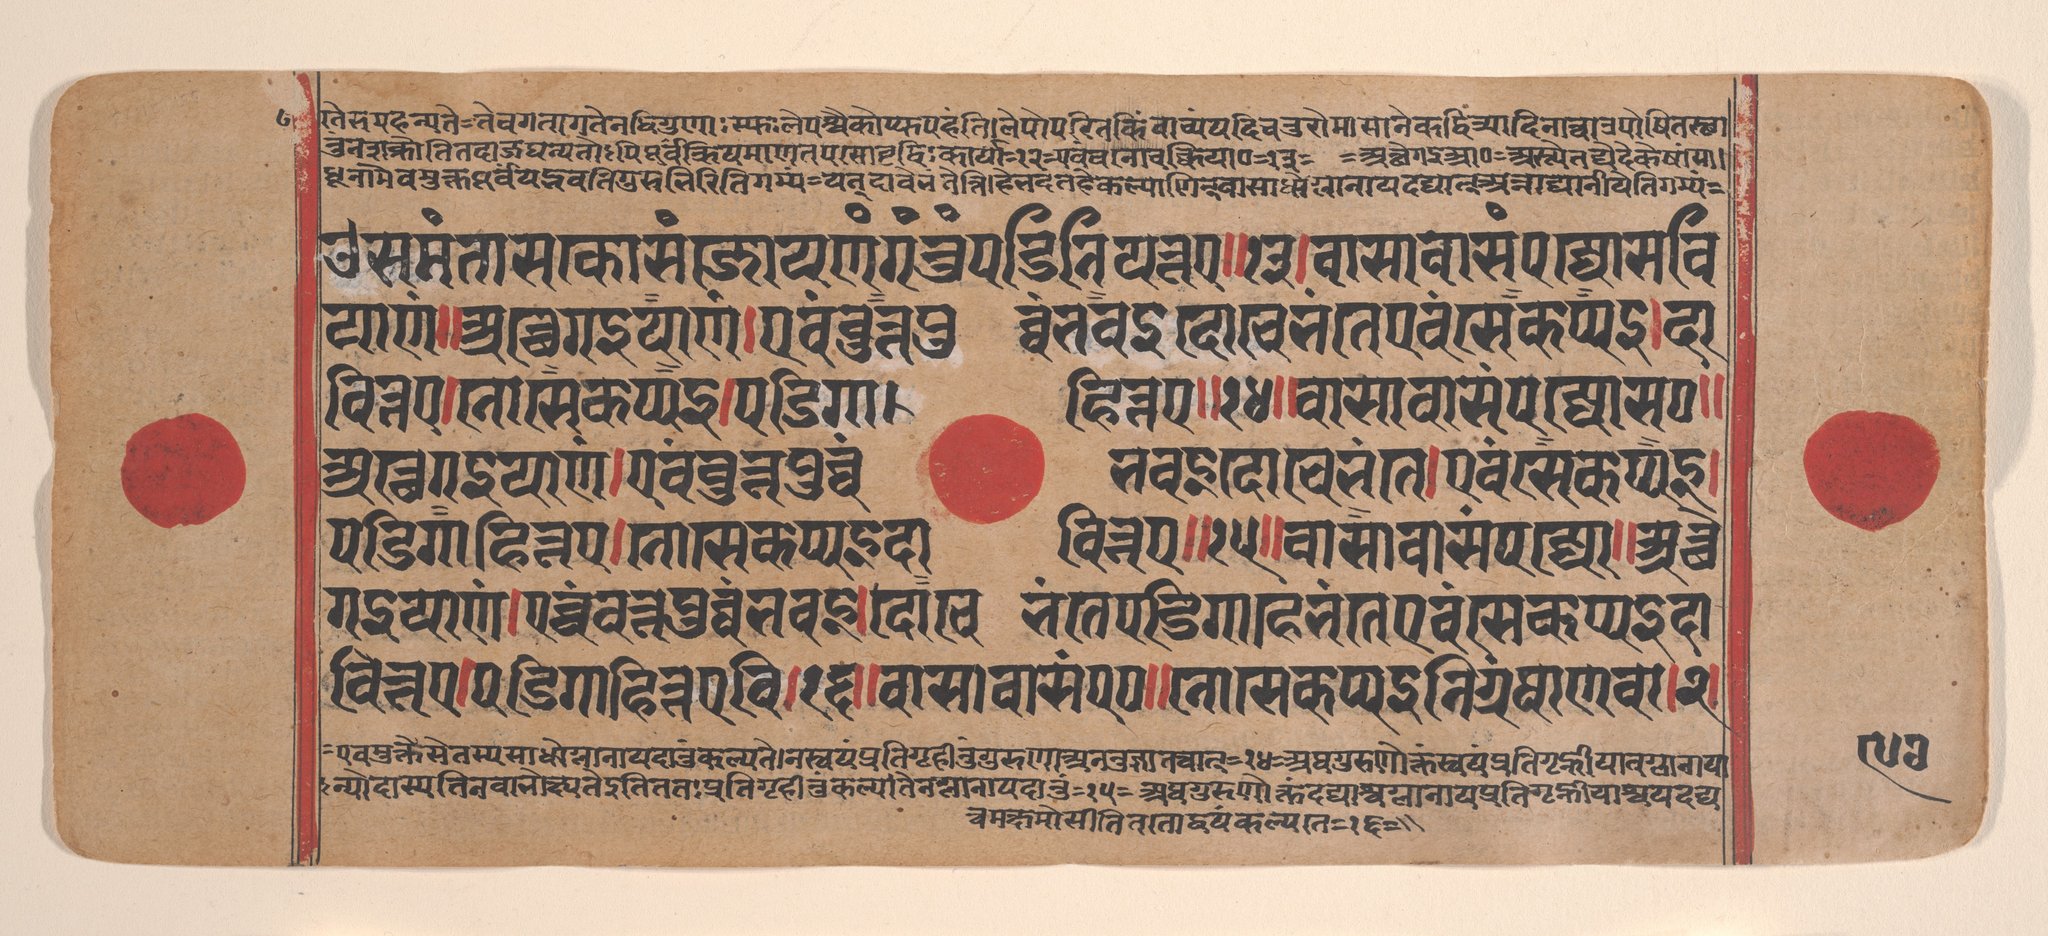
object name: folio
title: Page from a Dispersed Kalpa Sutra (Jain Book of Rituals)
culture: indian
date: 1401-1500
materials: gold, ink, paper, watercolor